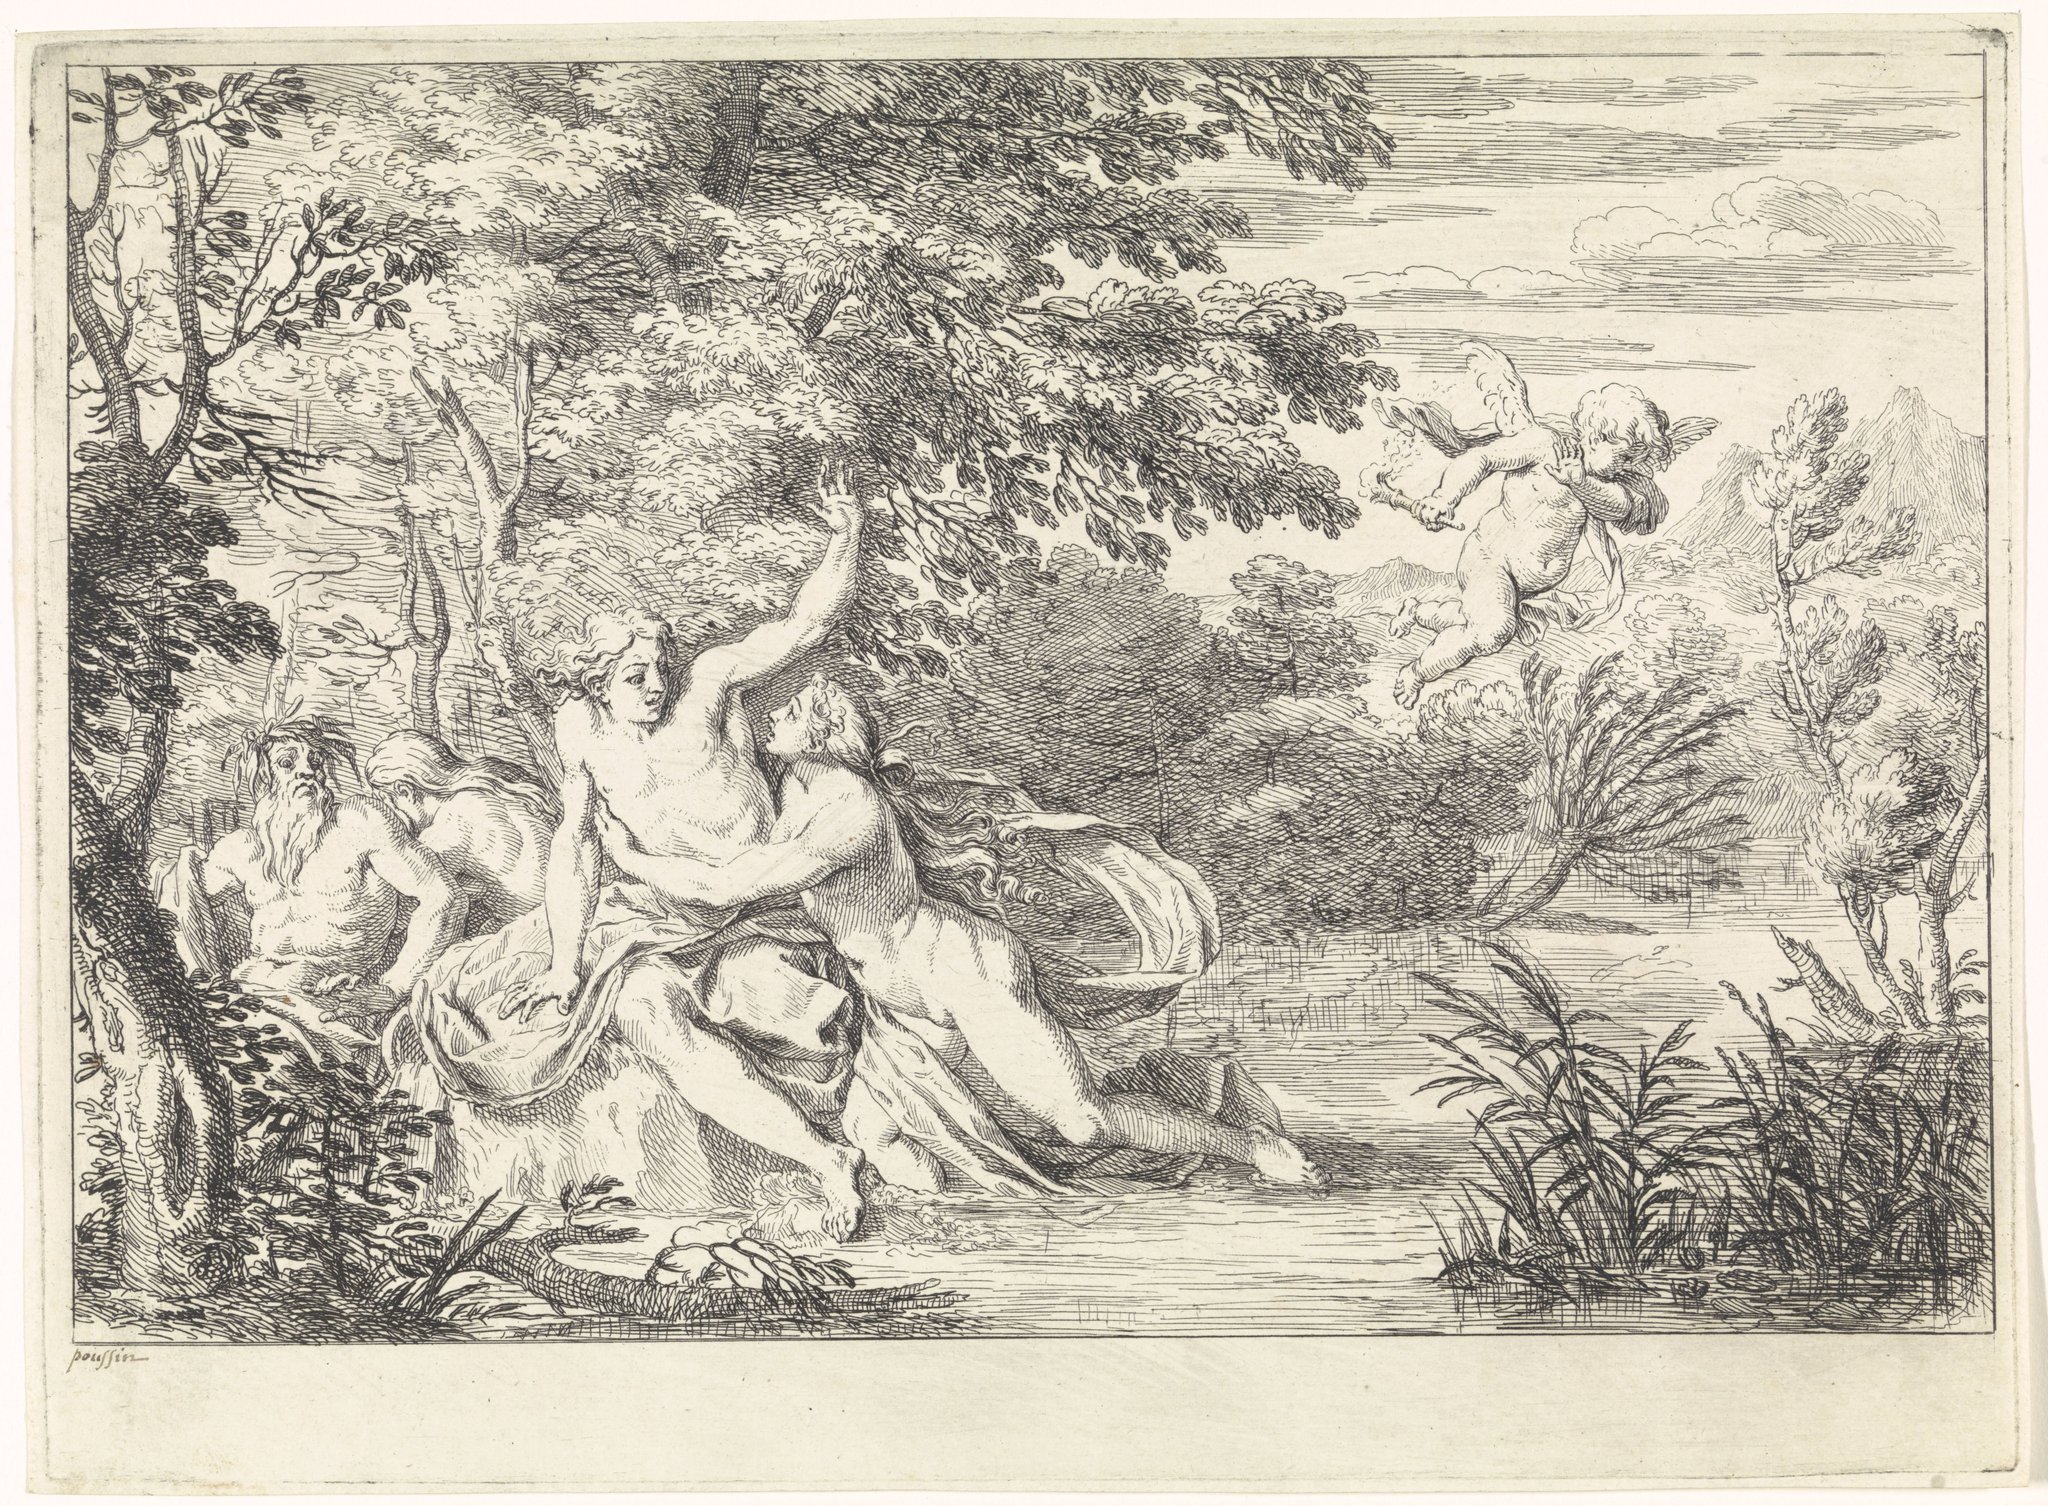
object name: print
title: Landschap met Byblis en Caunus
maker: bernard picart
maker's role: draughtsman, print maker, publisher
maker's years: 1673-1733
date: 1683-1733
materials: paper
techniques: etching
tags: byblis changed into a fountain: after looking for caunus everywhere, byblis at last lies down, bathed in tears, and is changed into a fountain (ovid, metamorphoses ix 663), byblis falls in love with her brother caunus, who scorns her love, (story of) cupid, amor (eros)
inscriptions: inscription: ‘Poussin’, collector's mark: Lugt 2228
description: Definitieve genummerde staat van deze prent opgenomen in: Impostures innocentes, ou recueil d'estampes d'apres divers peintres (...) par Bernard Picart (...) avec son elogue historique et le catalogue de ses ouvrages. Amsterdam: weduwe Bernard Picart, 1734.